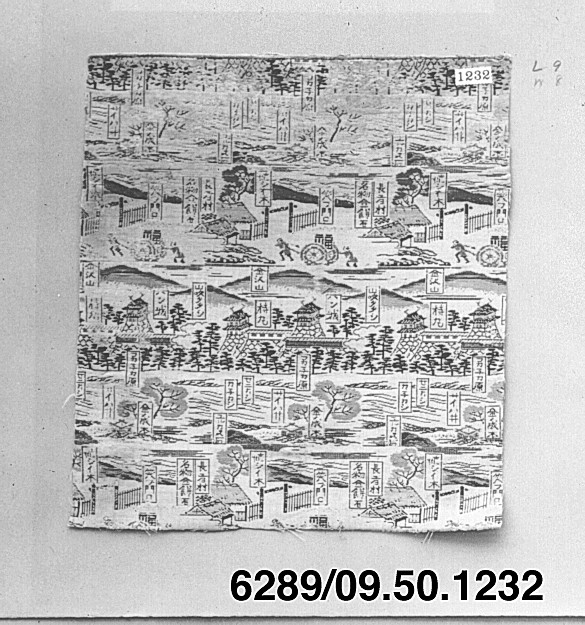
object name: piece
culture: japanese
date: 1801-1900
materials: silk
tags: gates,houses